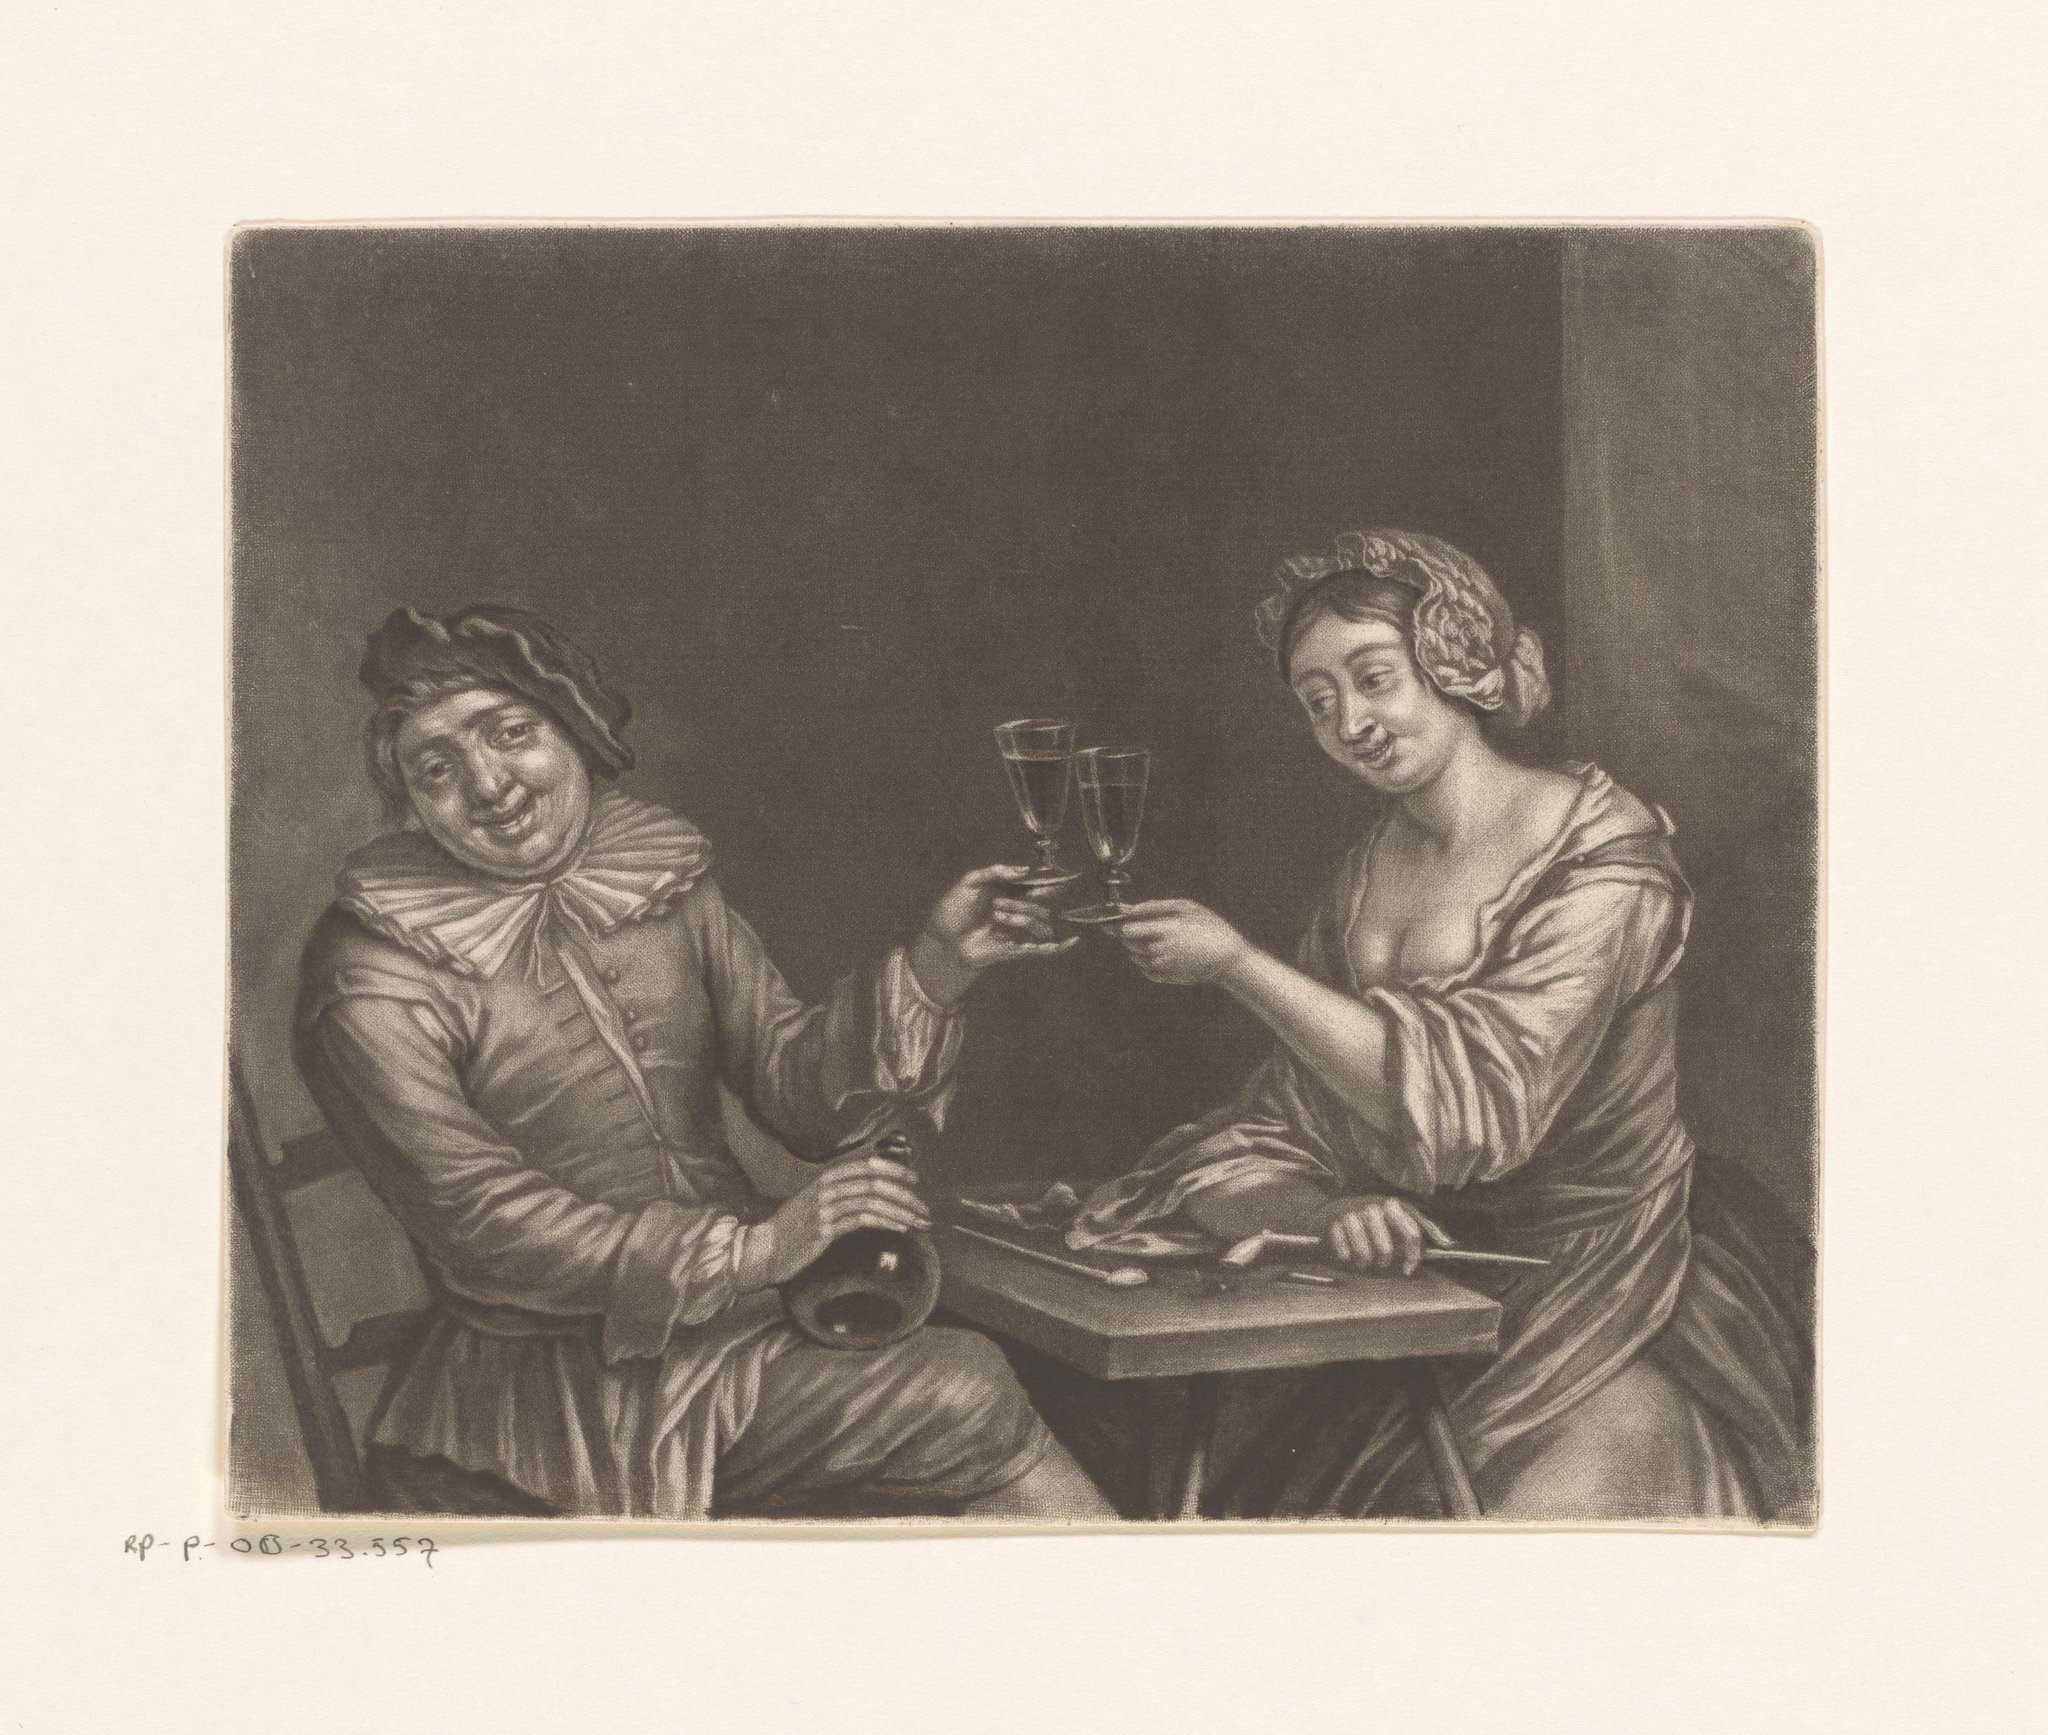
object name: print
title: Proostende man en vrouw aan tafel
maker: Anonymous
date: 1670-1720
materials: paper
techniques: mezzotint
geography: england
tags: pipe ~ tobacco, laughing, alcoholic drinks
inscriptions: collector's mark: Lugt 240